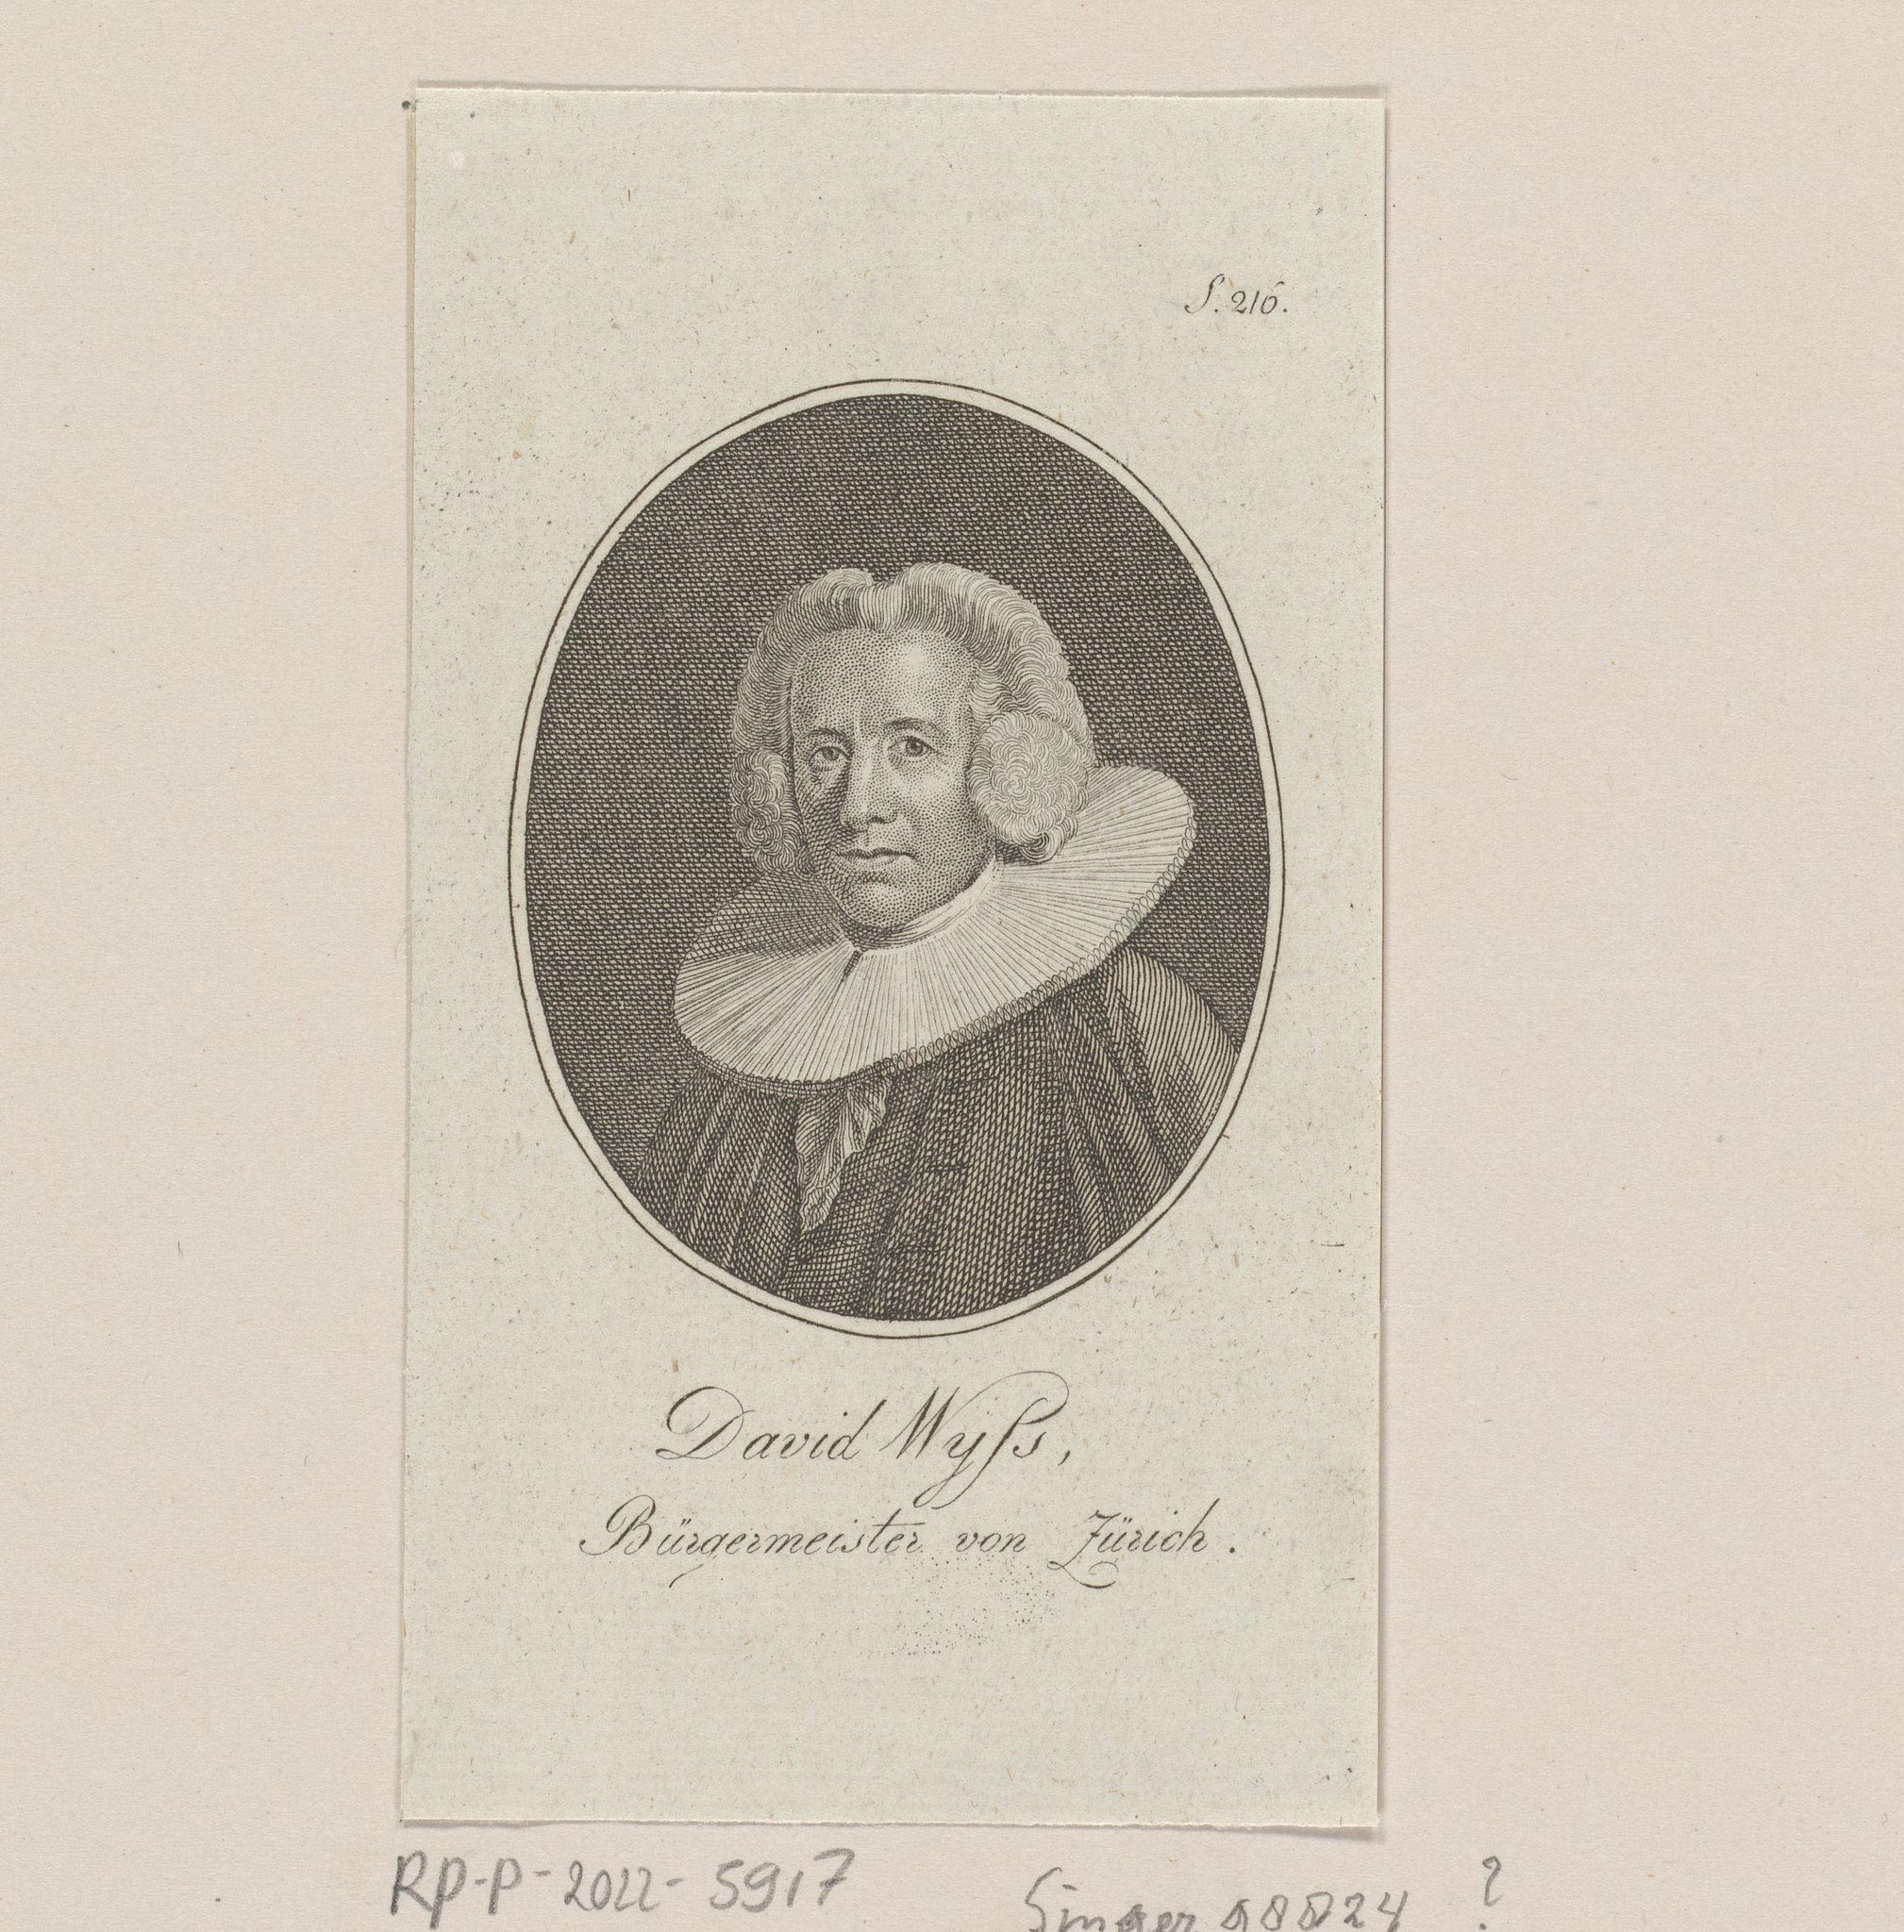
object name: book illustration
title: Portret van David von Wyss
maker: Anonymous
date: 1795-1798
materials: paper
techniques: etching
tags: mayor, burgomaster, historical persons